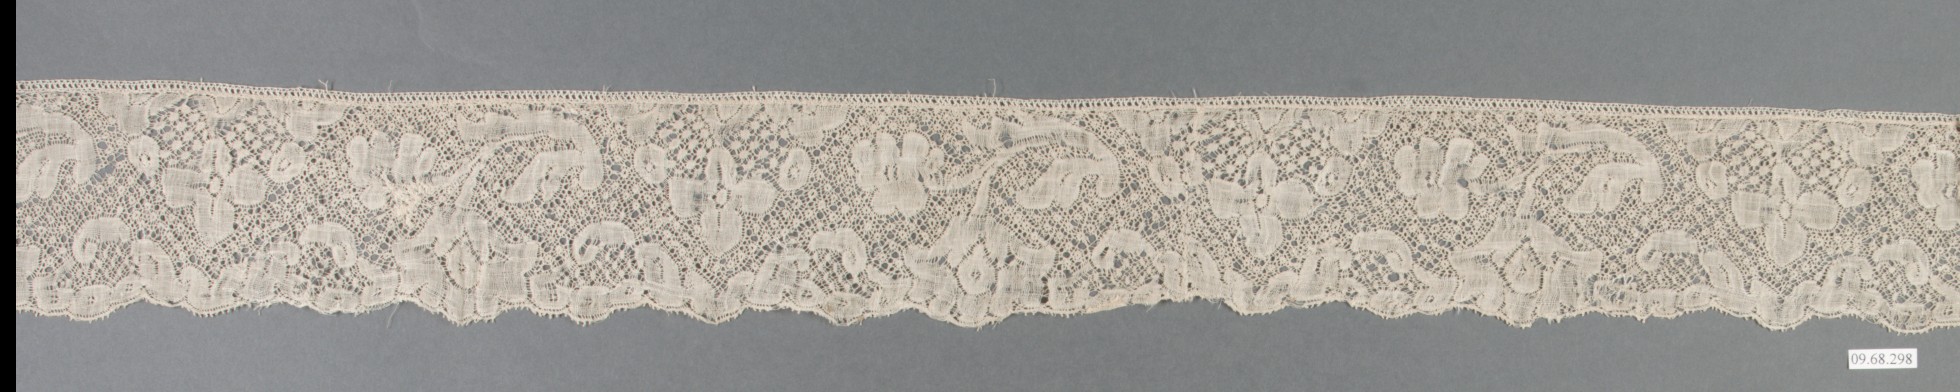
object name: strip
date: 1701-1800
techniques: lace